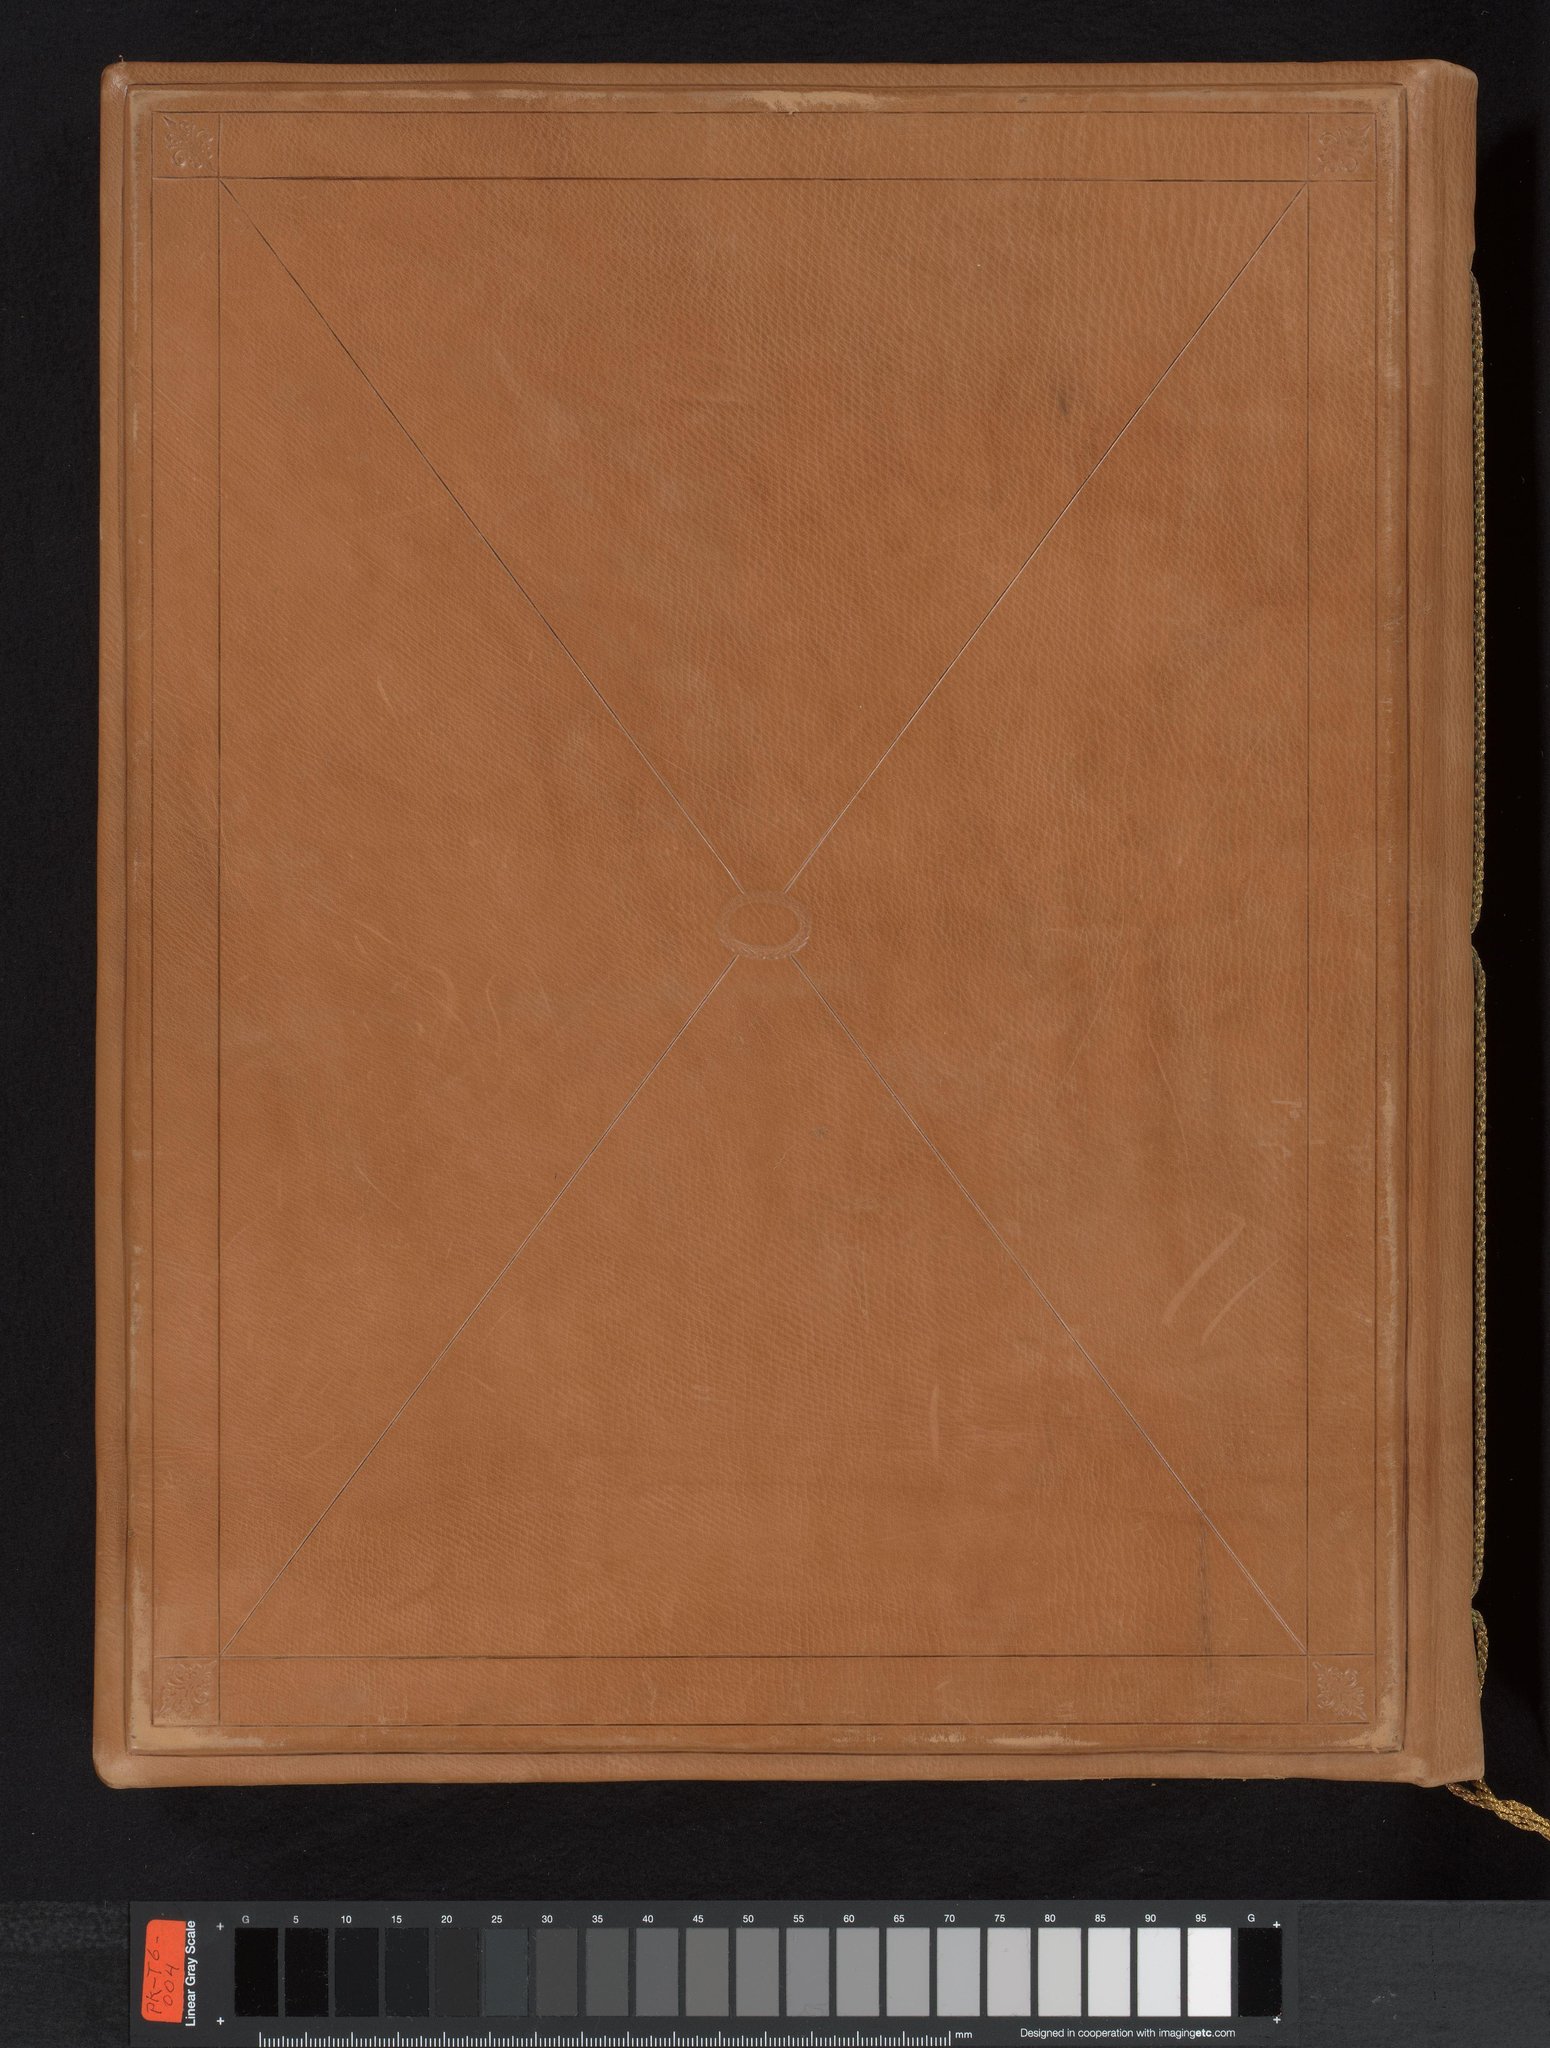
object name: text sheet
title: Blad met handtekeningen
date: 1949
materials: ink, paper, pencil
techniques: handwriting, pen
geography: netherlands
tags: modern professional organization, trade union, reception, cocktail party, handwriting, written text, amsterdam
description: Blad met handtekeningen van aanwezigen op het afscheidsfeest. Onderdeel van het fotoalbum ter gelegenheid van het afscheid van Evert Kupers als voorzitter van de NVV op 14 juli 1949 in Amsterdam.